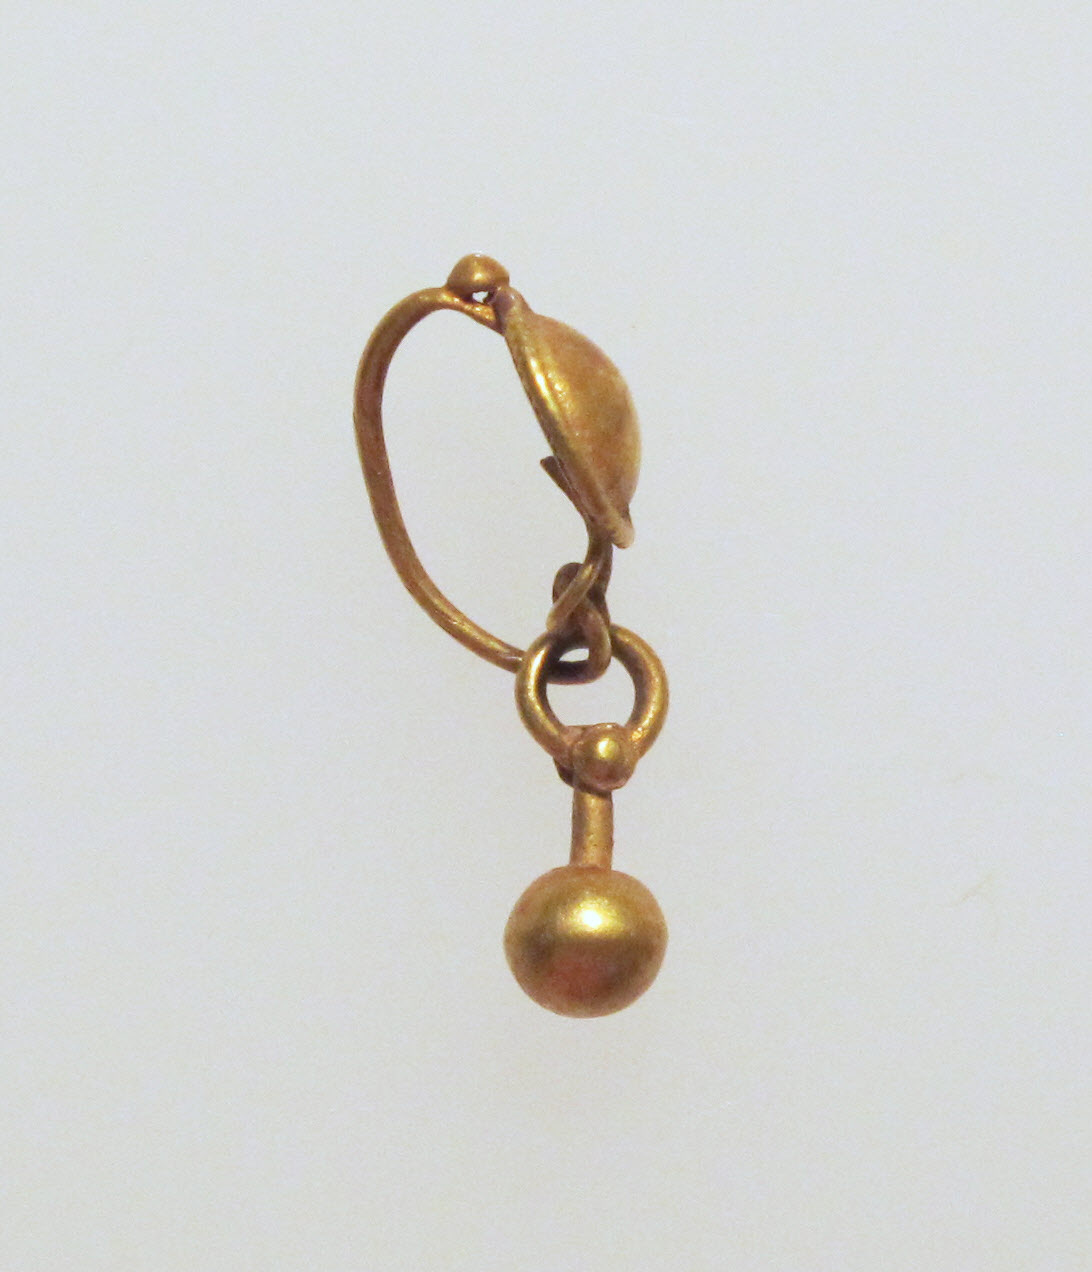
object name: earring with pendant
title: Gold earring with disc and pendant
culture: roman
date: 101-200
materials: gold